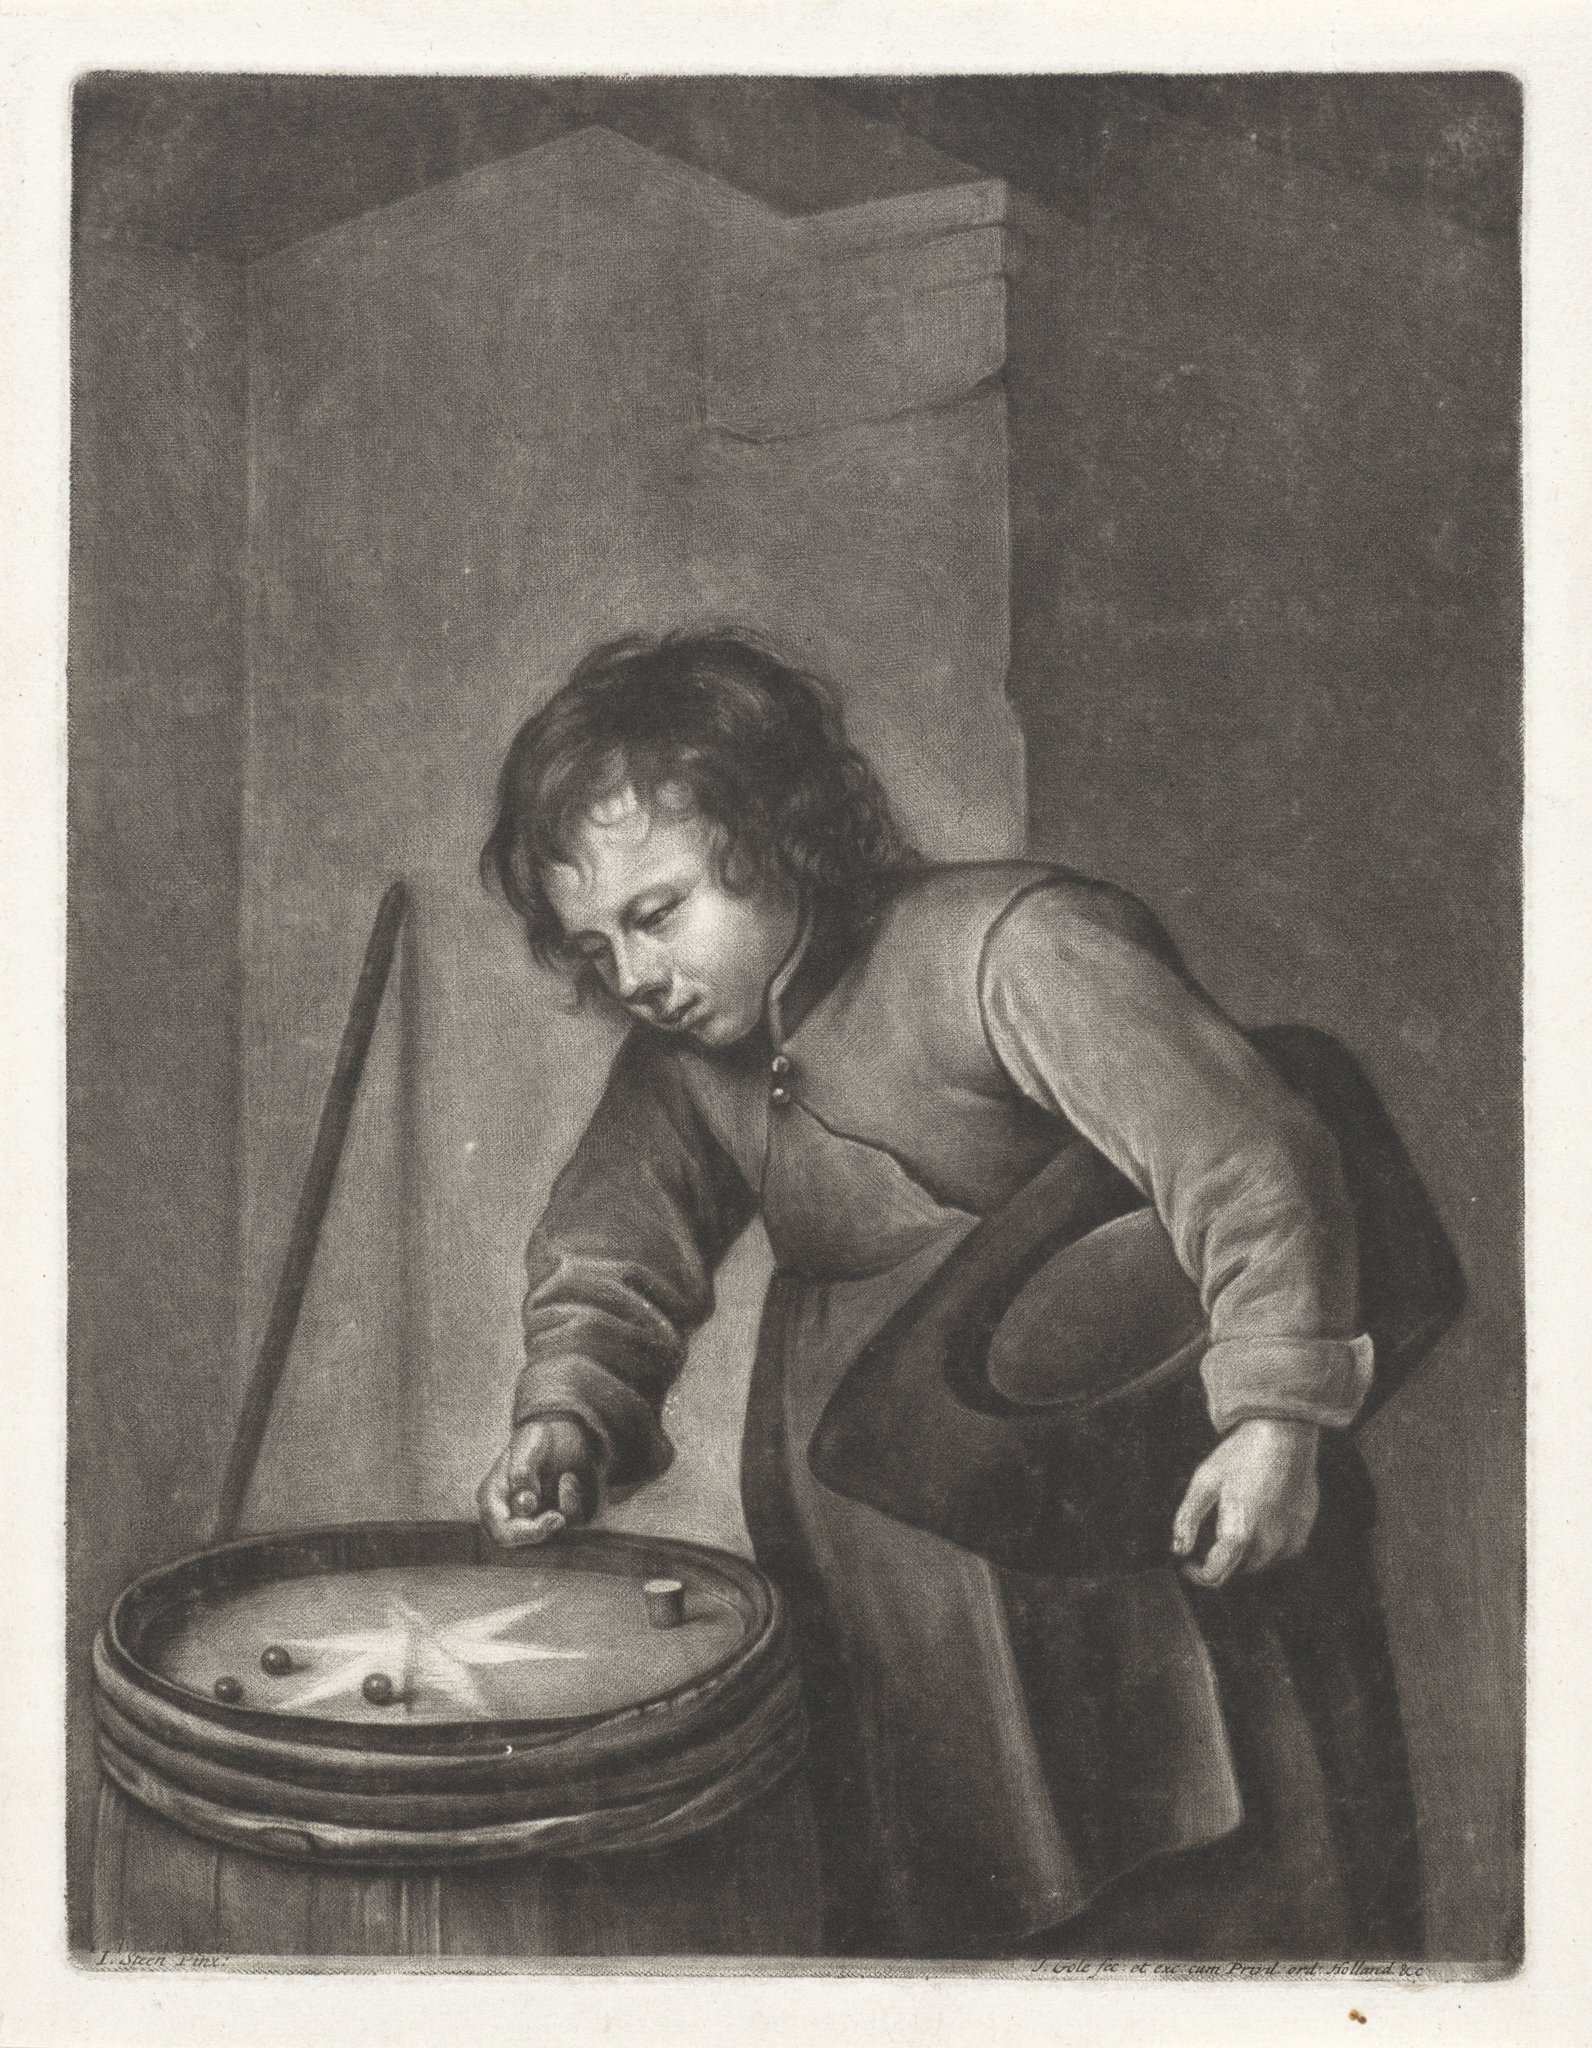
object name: print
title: Knikkerende jongen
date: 1670-1724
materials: paper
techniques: etching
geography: amsterdam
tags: (playing at) marbles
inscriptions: collector's mark: Lugt 240